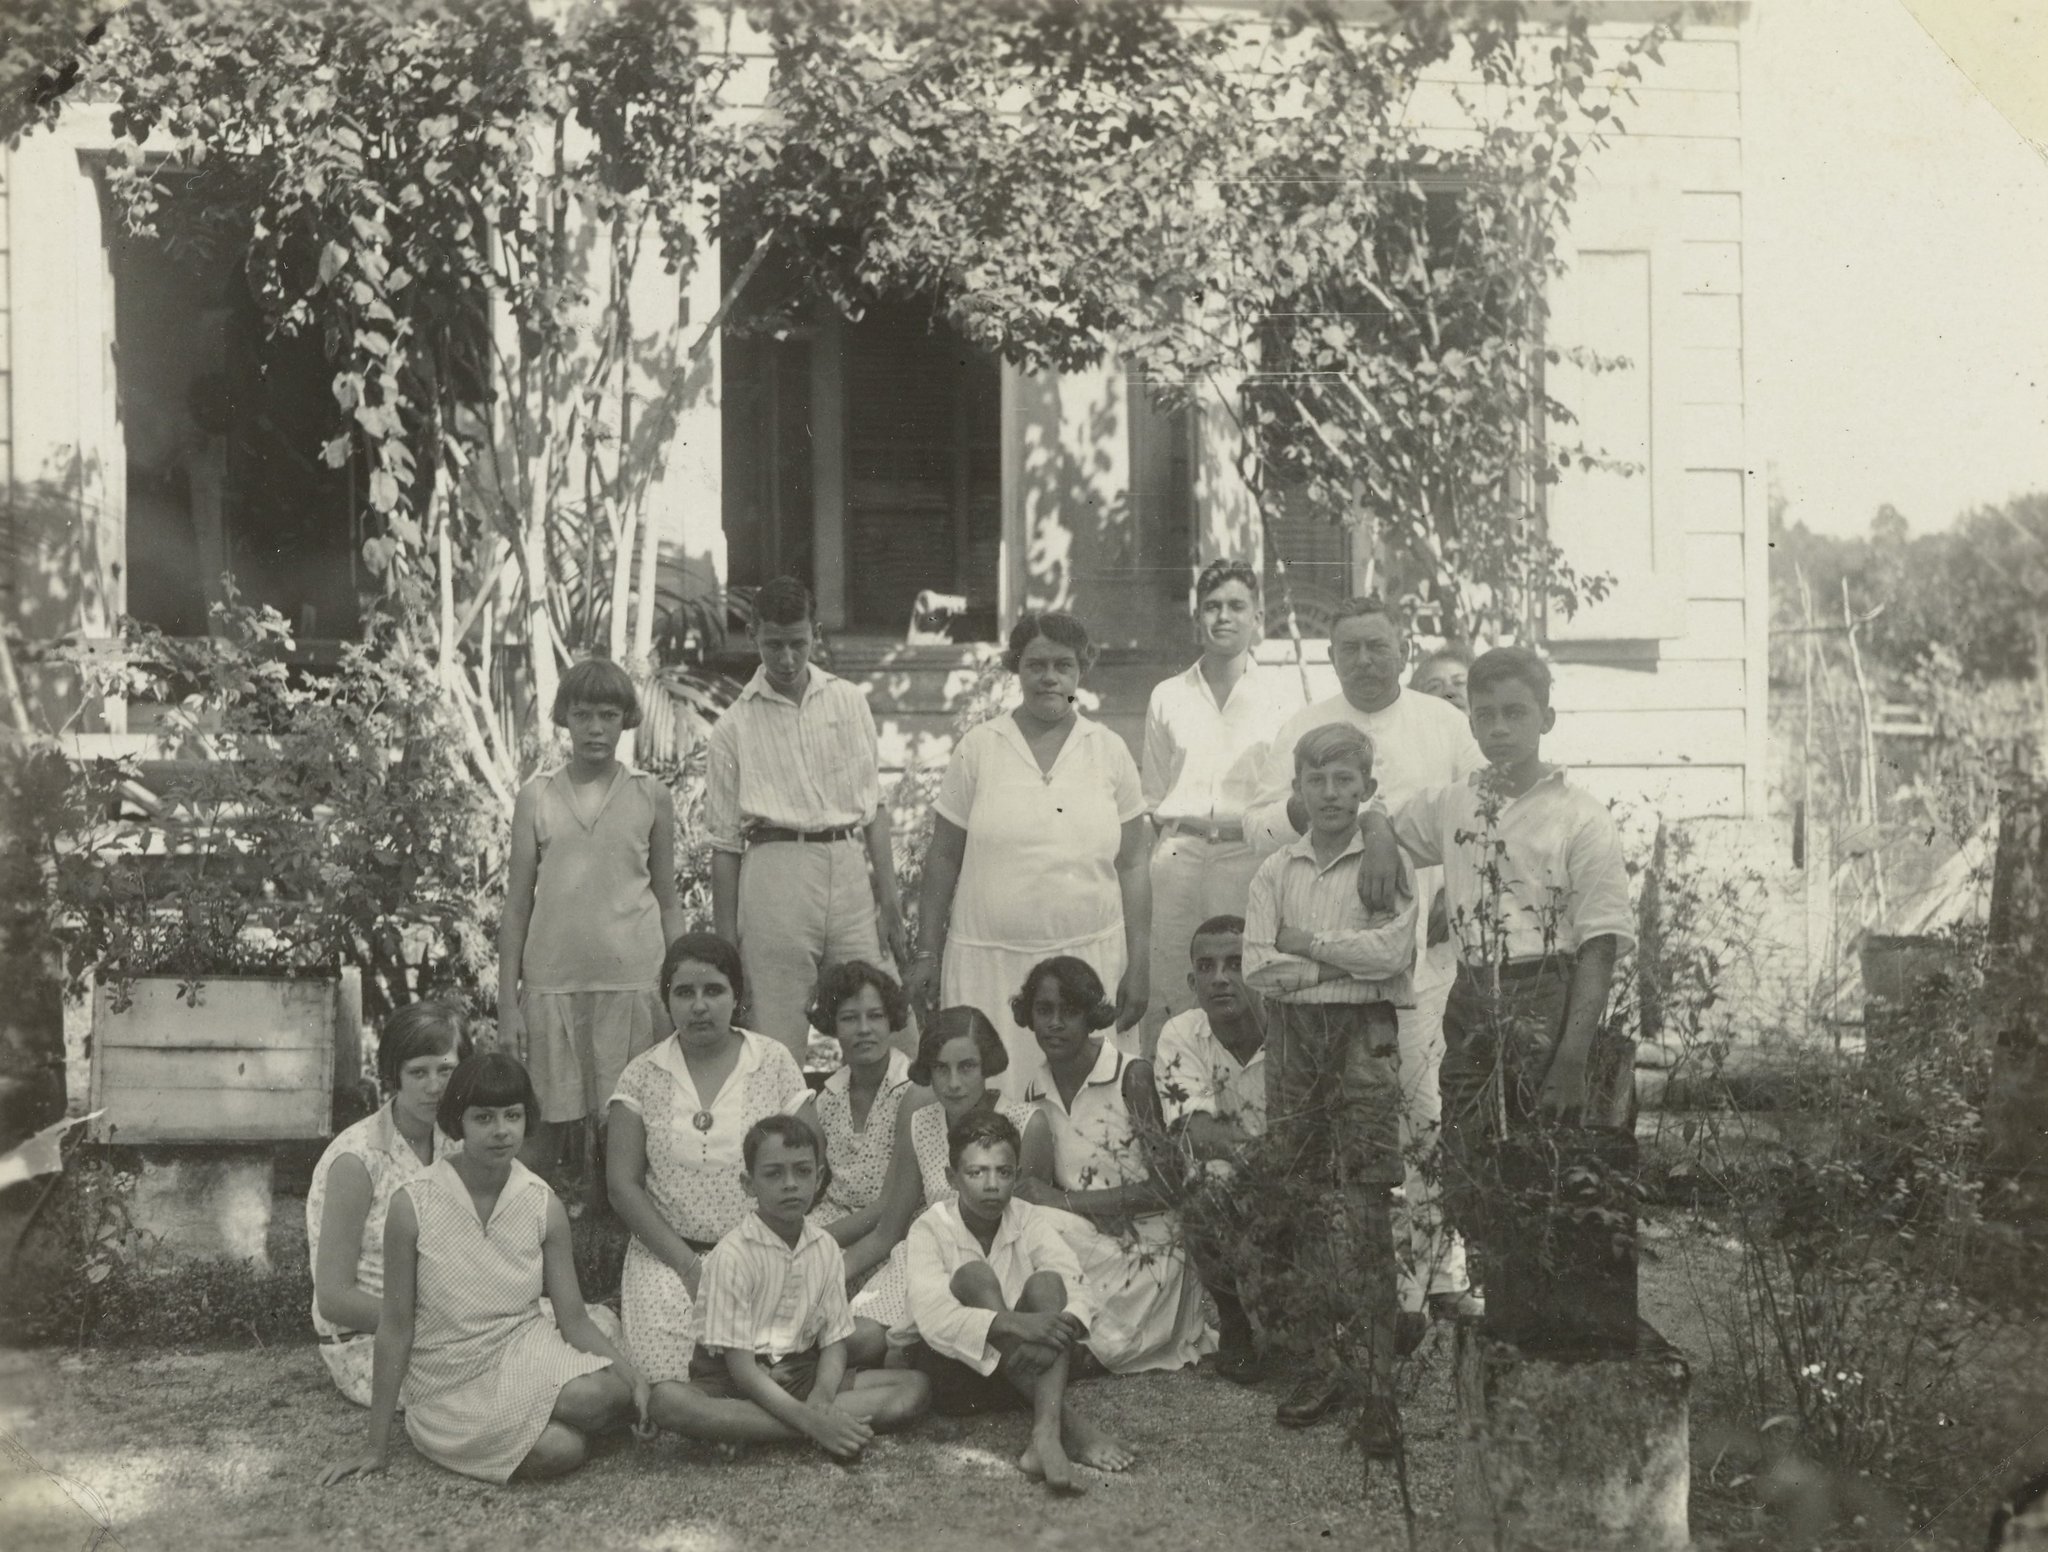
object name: photograph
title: Groepsportret op plantage Accaribo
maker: Anonymous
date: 1926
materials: photographic support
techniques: photography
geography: suriname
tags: amsterdam, theodoor brouwers, suriname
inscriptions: inscription: ‘"26 Accaribo’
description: Groepsportret op plantage Accaribo te Suriname. Bijna helemaal rechts op de foto staat Theodoor Brouwers. De jongen links van hem (tussen het echtpaar Brouwers in) is Gerard Brouwers (1912-1996), de zoon van Theodoor Brouwers.